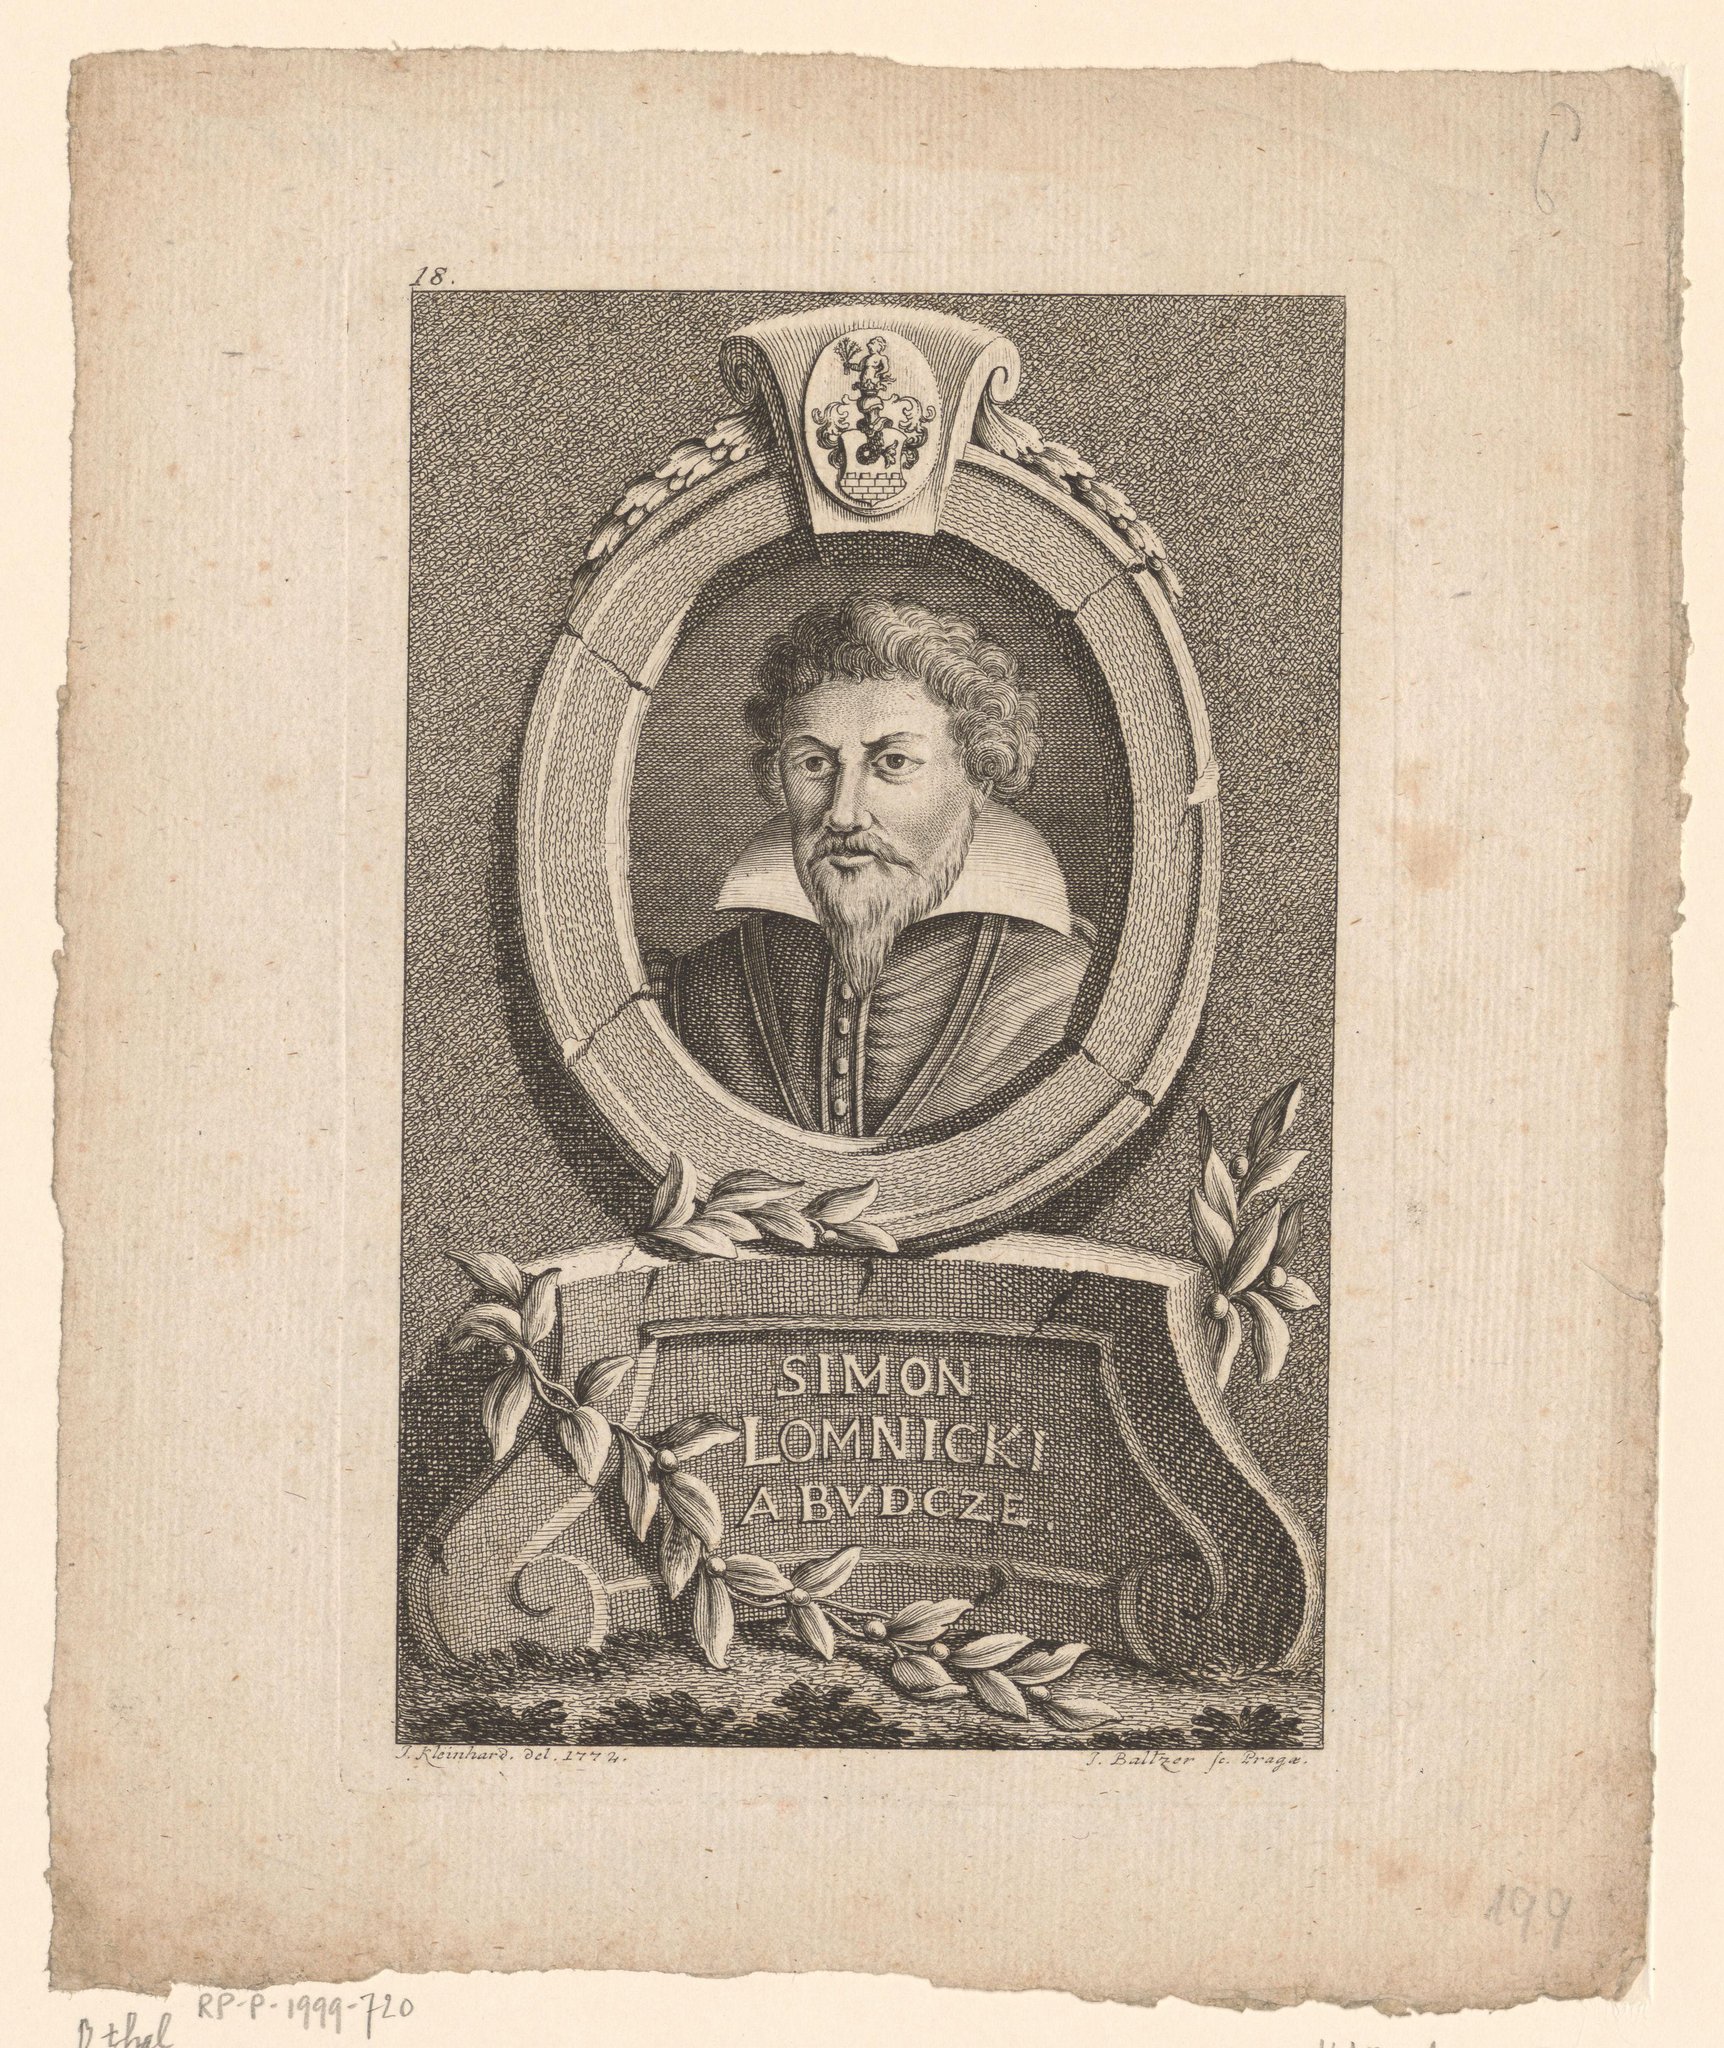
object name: print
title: Portret van Simon Lomniczky von Budecz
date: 1773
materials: paper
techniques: engraving, etching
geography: prague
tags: prague, ornament ~ medallion, historical persons, portrait of a writer, armorial bearing, heraldry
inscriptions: collector's mark: Lugt 2228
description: Prent waarschijnlijk uit: Effigies virorum eruditorum atque artificum Bohemiae et Moraviae (...). Praag: Wolfgang Gerle, 1773, dl. 1.